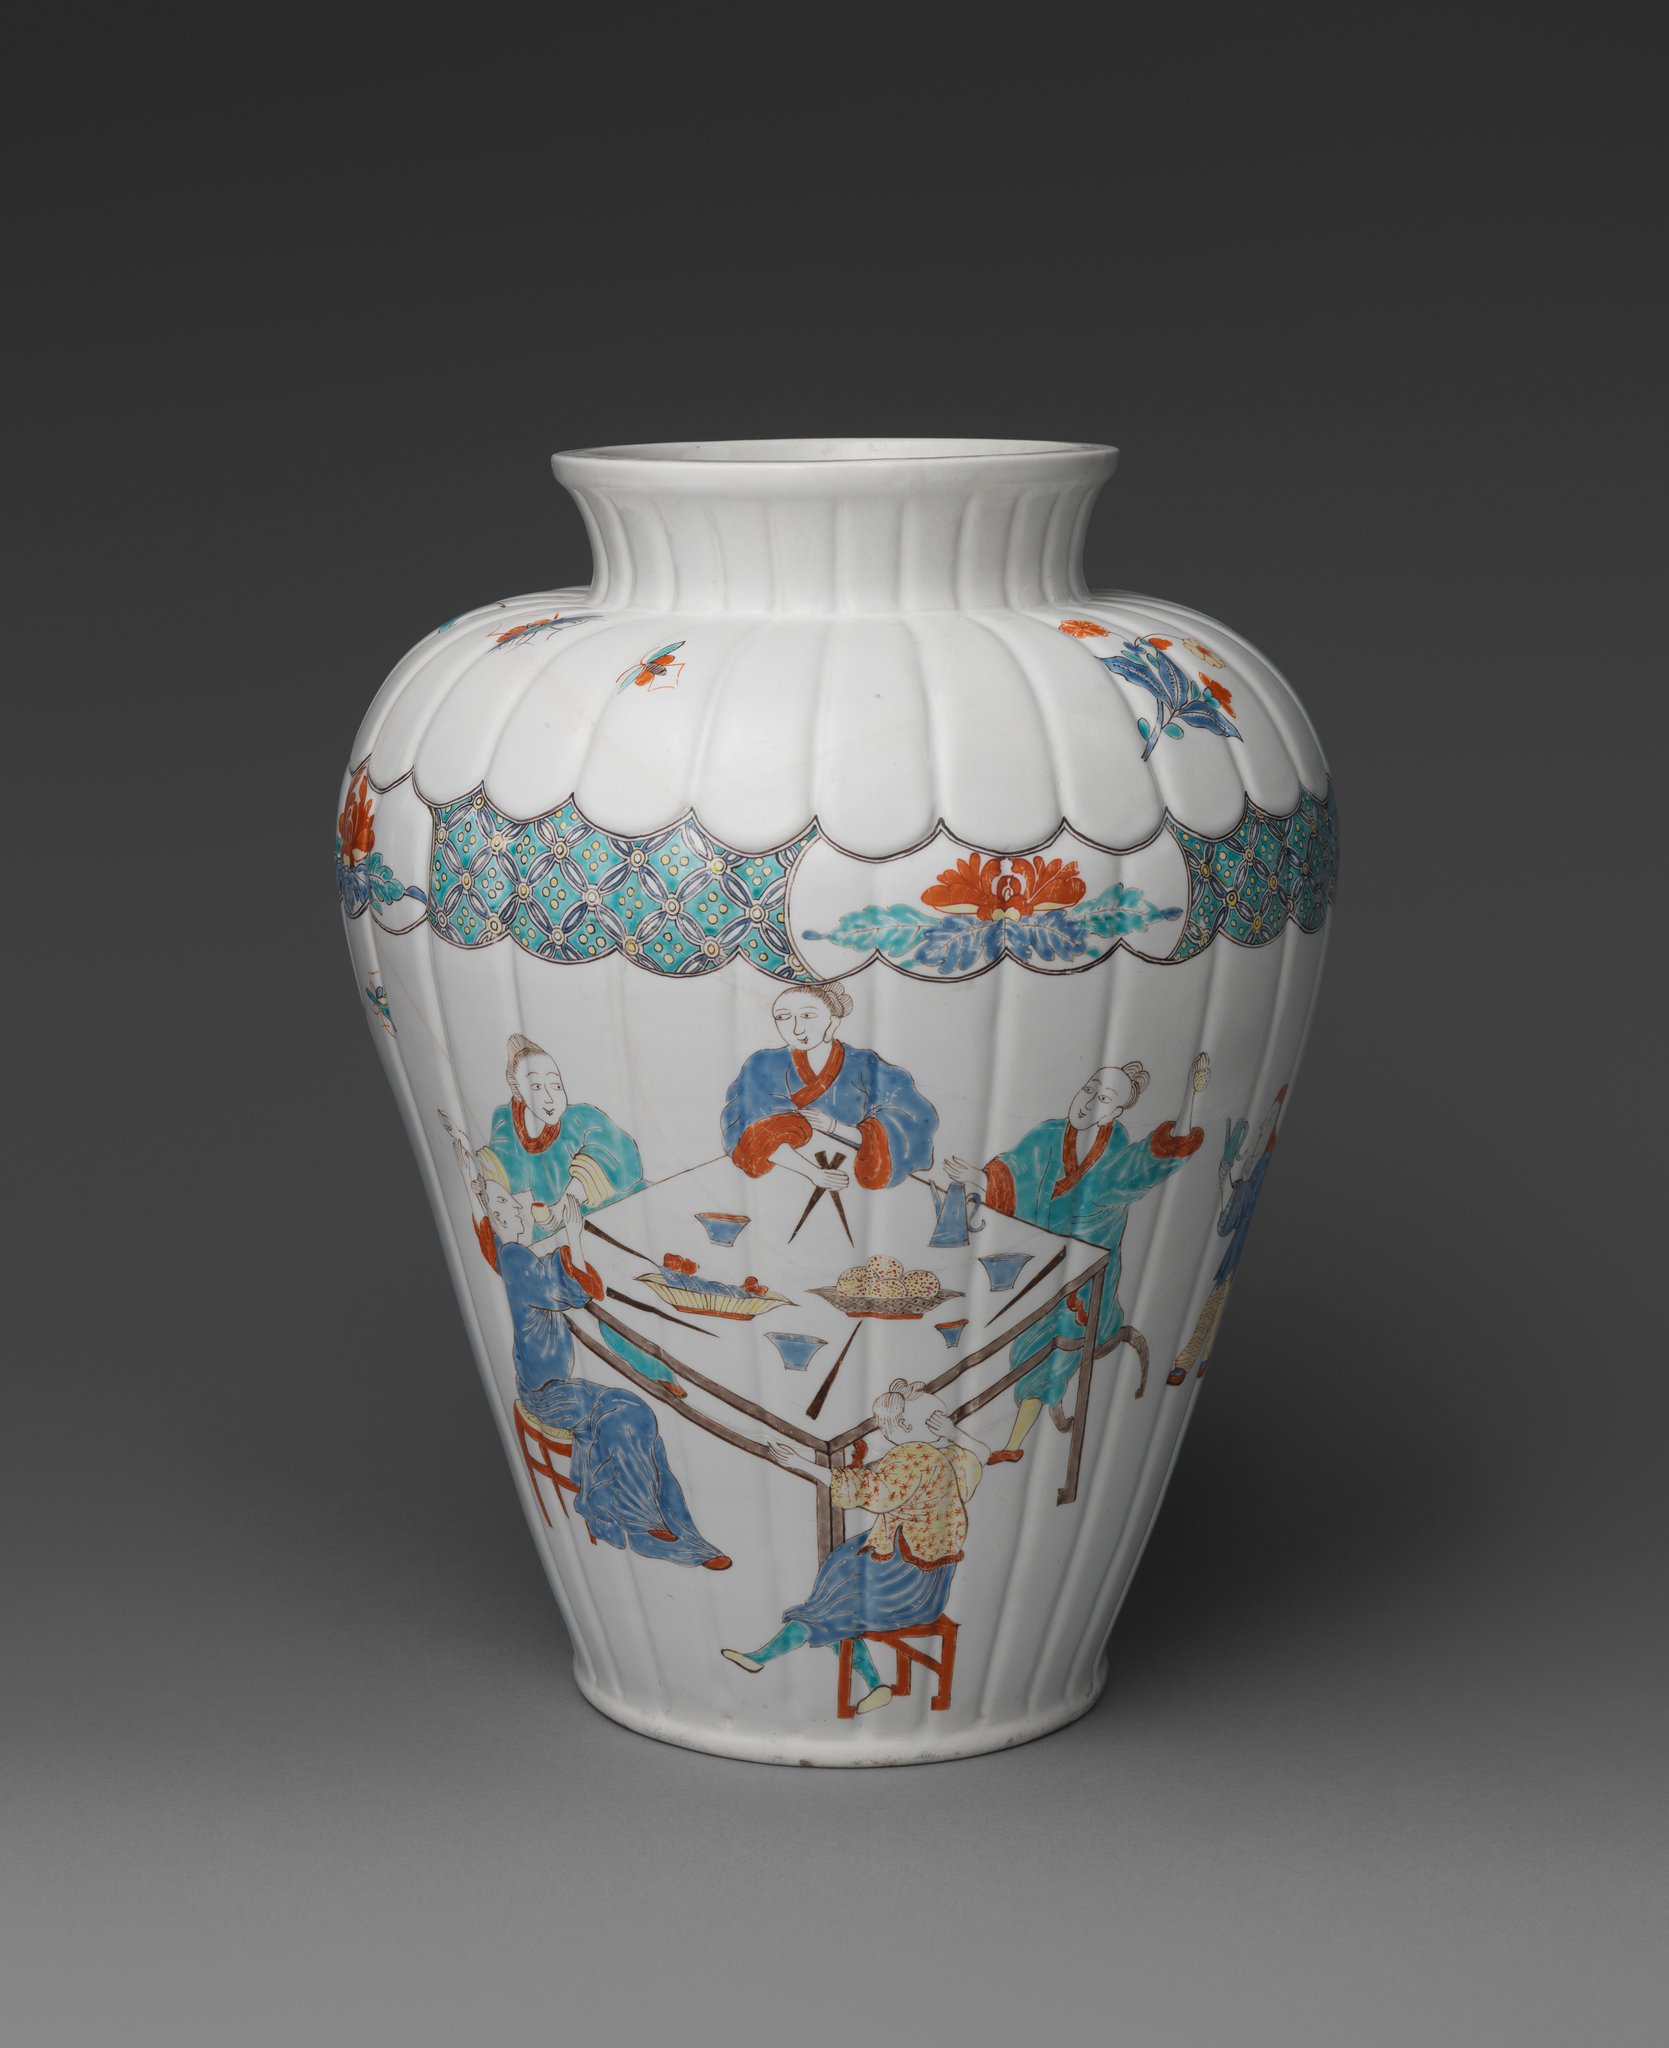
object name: jar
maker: chantilly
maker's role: manufactory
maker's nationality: french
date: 1735-1740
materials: enamel, soft paste porcelain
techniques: polychrome, glazing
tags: men,women,dining